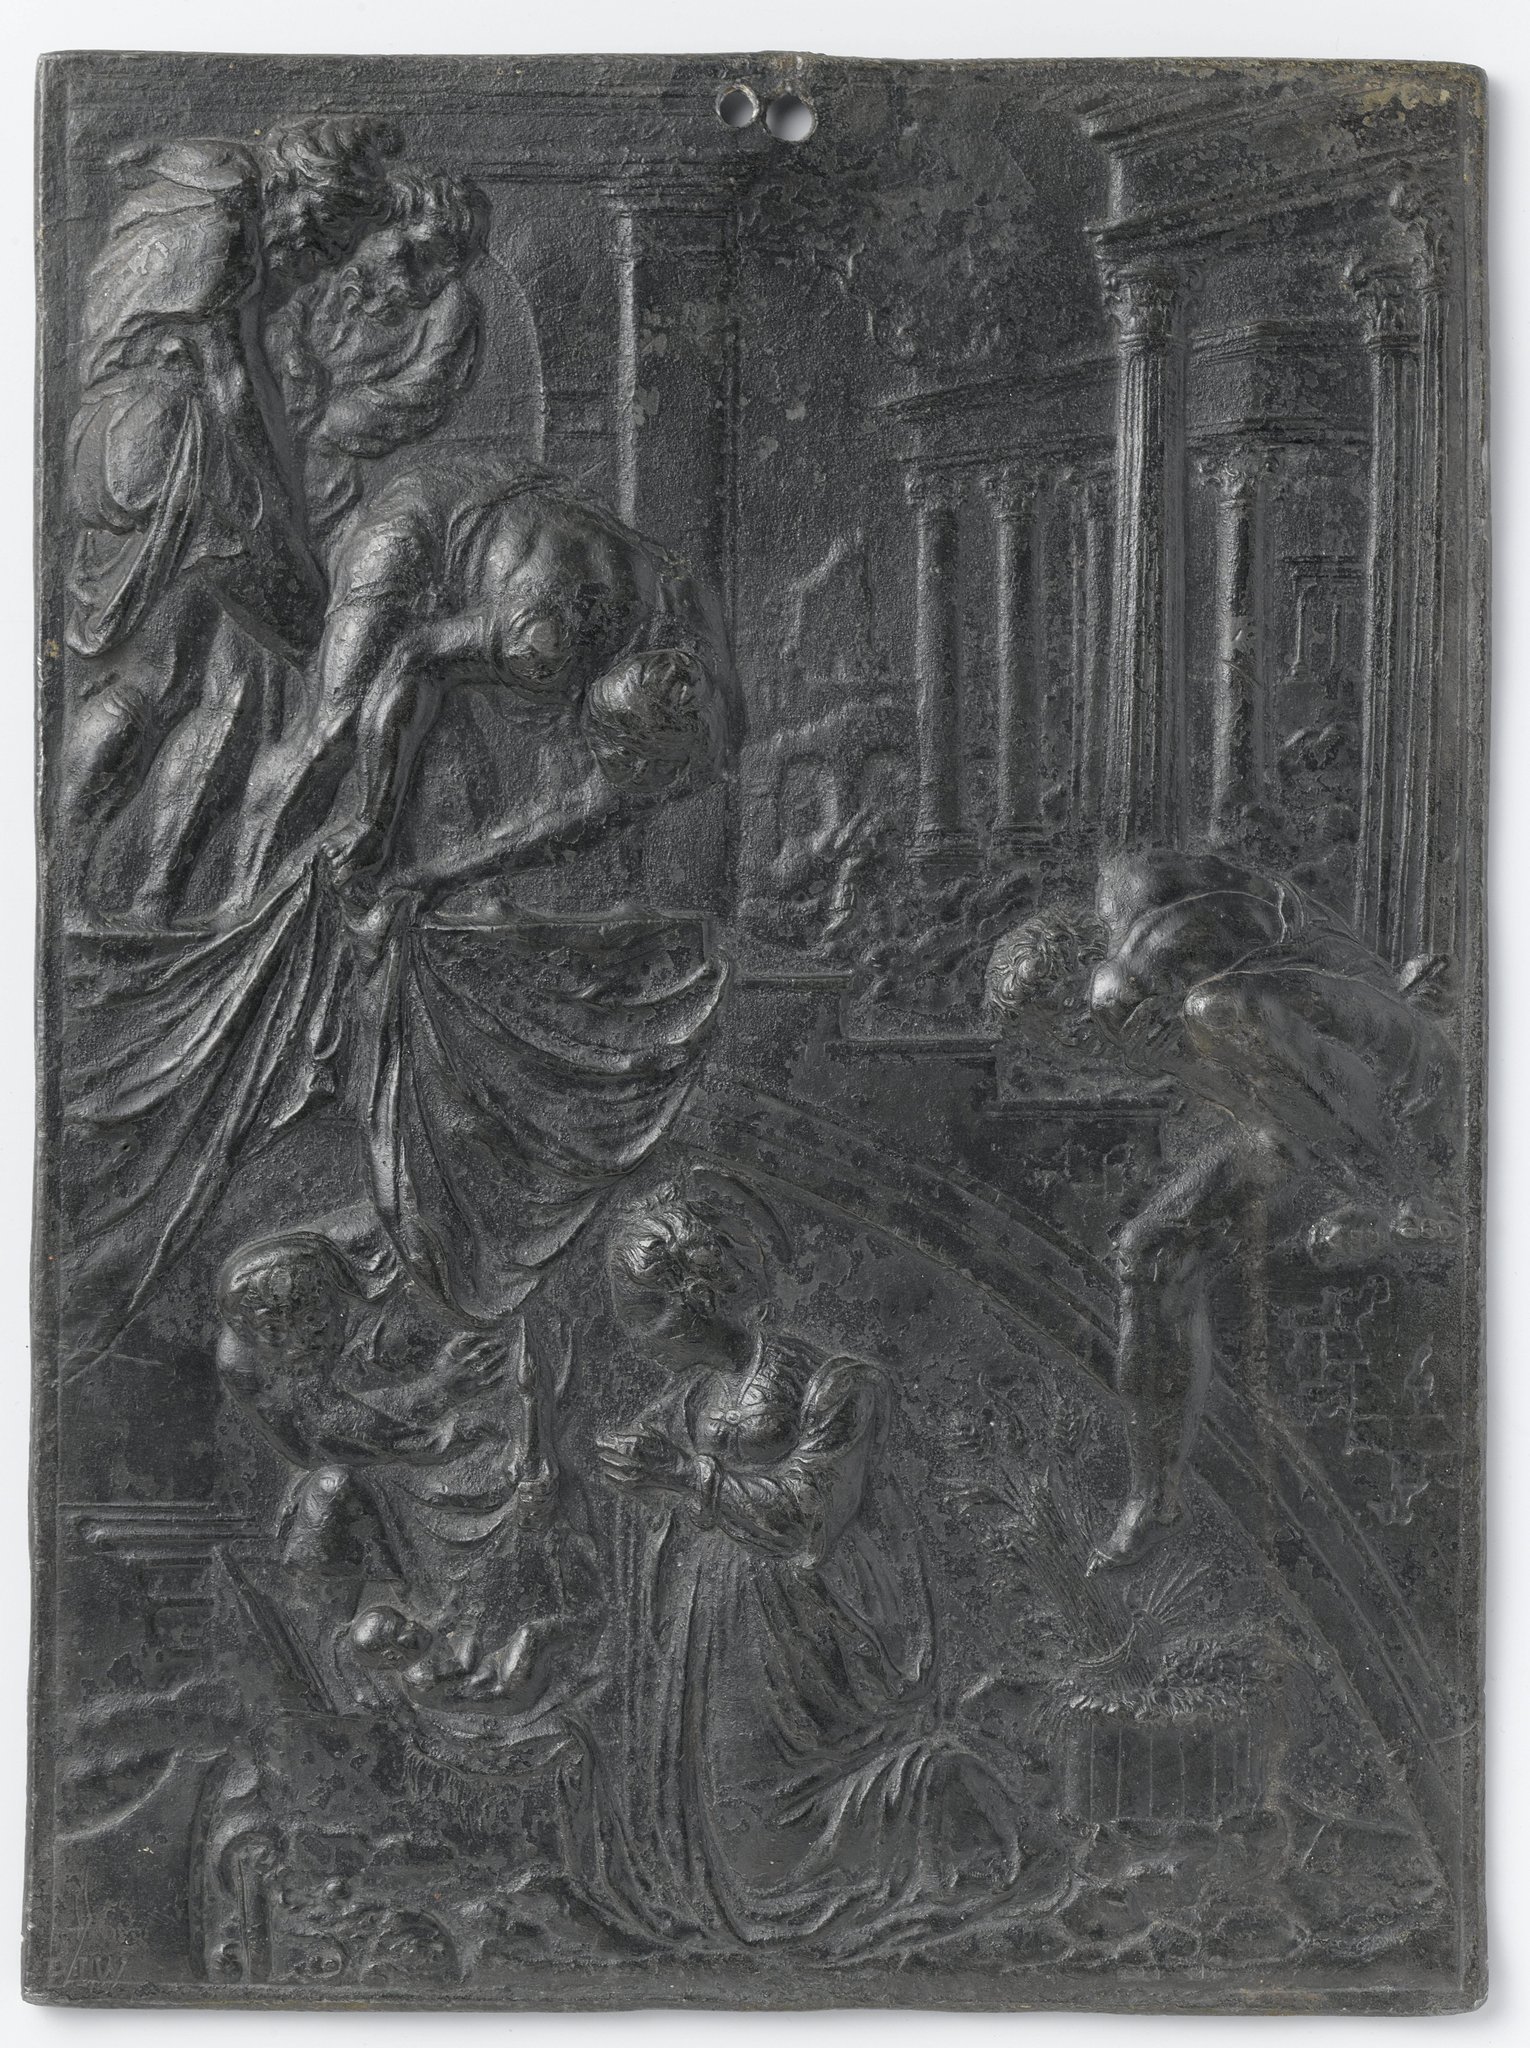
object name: sculpture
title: Geboorte van Christus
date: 1525-1575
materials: lead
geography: italy